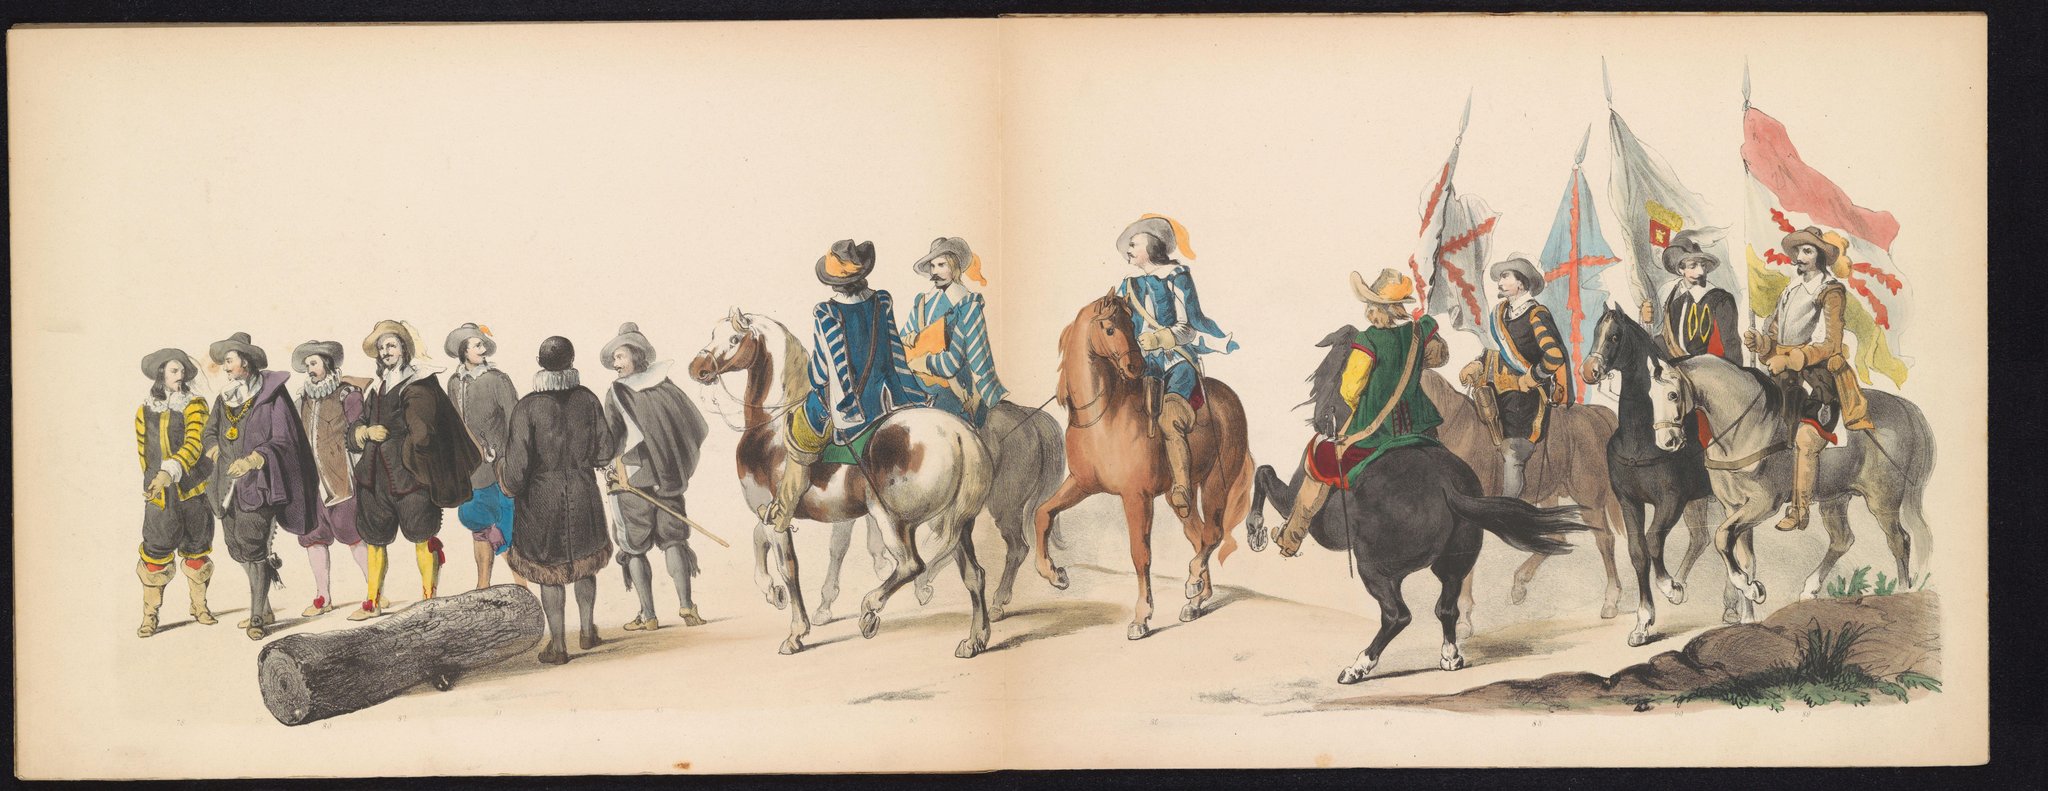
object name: print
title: Intogt van Frederik Hendrik in 's Hertogenbosch in 1629 : gecostumeerde voorstelling door de H.H. studenten der Leydsche Hoogeschool den XI Junij van het jaar 1850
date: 1850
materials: paper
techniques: lithograph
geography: the hague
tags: delft, the hague, frederick henry (prince of orange), students' pageant, costumes used in pageants, leiden, den bosch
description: Historische gekostumeerde optocht van de studenten van de Leidse Hogeschool op 11 juni 1850. De optocht verbeeldt de intocht van Frederik Hendrik te Den Bosch in 1629. Negende plaat met de groepen genummerd 78-90. Onderdeel van de serie van dertien aanelkaar geplakte bladen.